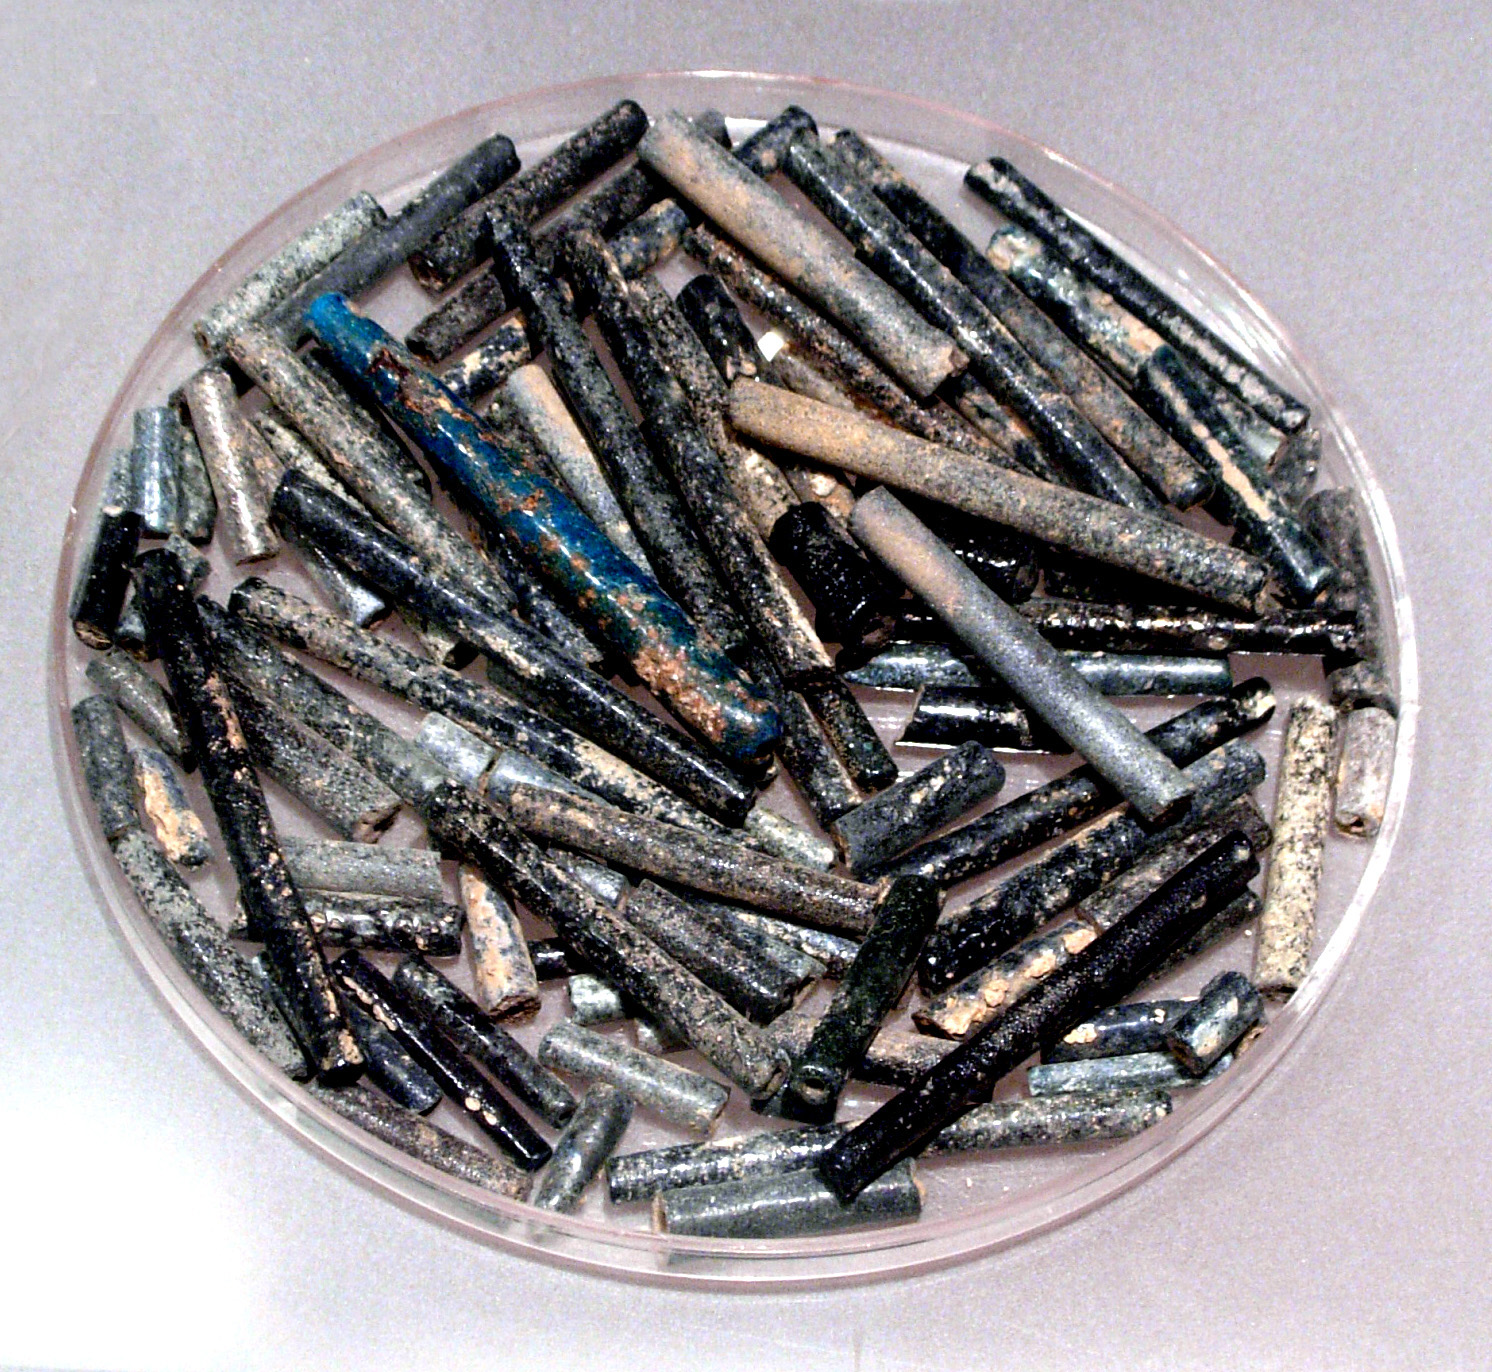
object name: bead, tubular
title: Tray of Tubular beads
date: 1802-1450 BCE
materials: faience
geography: egypt